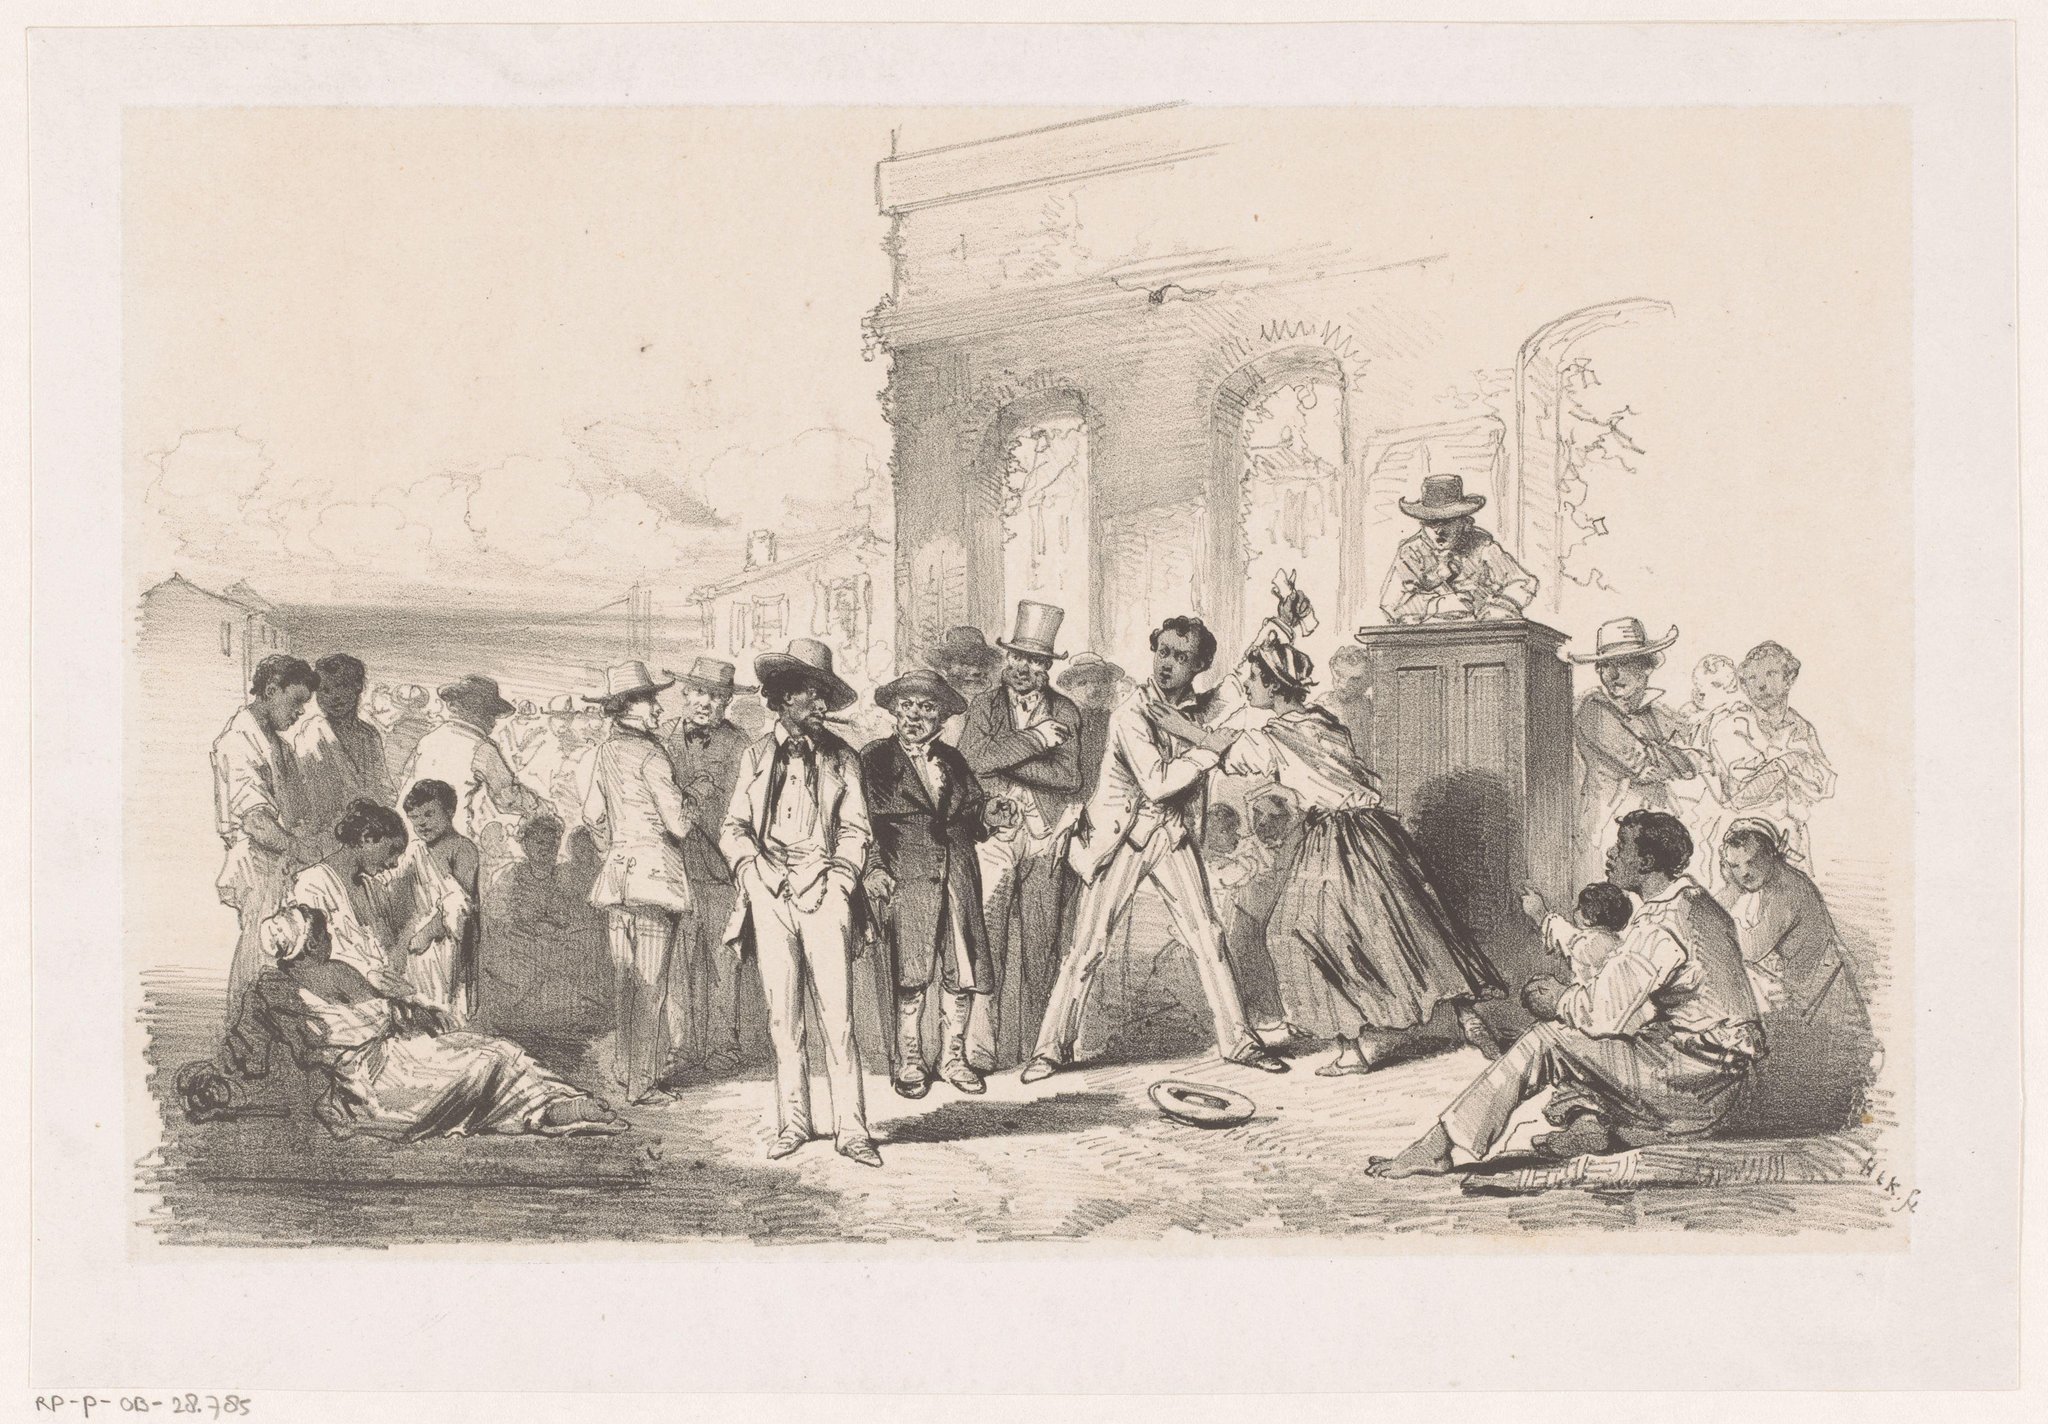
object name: print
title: Verhandeling van slaven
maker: mari ten kate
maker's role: draughtsman, painter, print maker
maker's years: 1831-1910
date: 1841-1910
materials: paper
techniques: tone lithography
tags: master ~ enslaved person, slave-trade, slavery; serfs and enslaved persons, auction sale, public sale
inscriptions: collector's mark: Lugt 2228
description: De veilingmeester staat achter een katheder. Bij hem staan handelaren en tot slaaf gemaakte mannen vrouwen en kinderen. In het midden probeert een zwarte man een andere zwarte man te overbieden. Hij steekt zijn bankbiljetten in de lucht maar wordt tegengehouden door een vrouw.